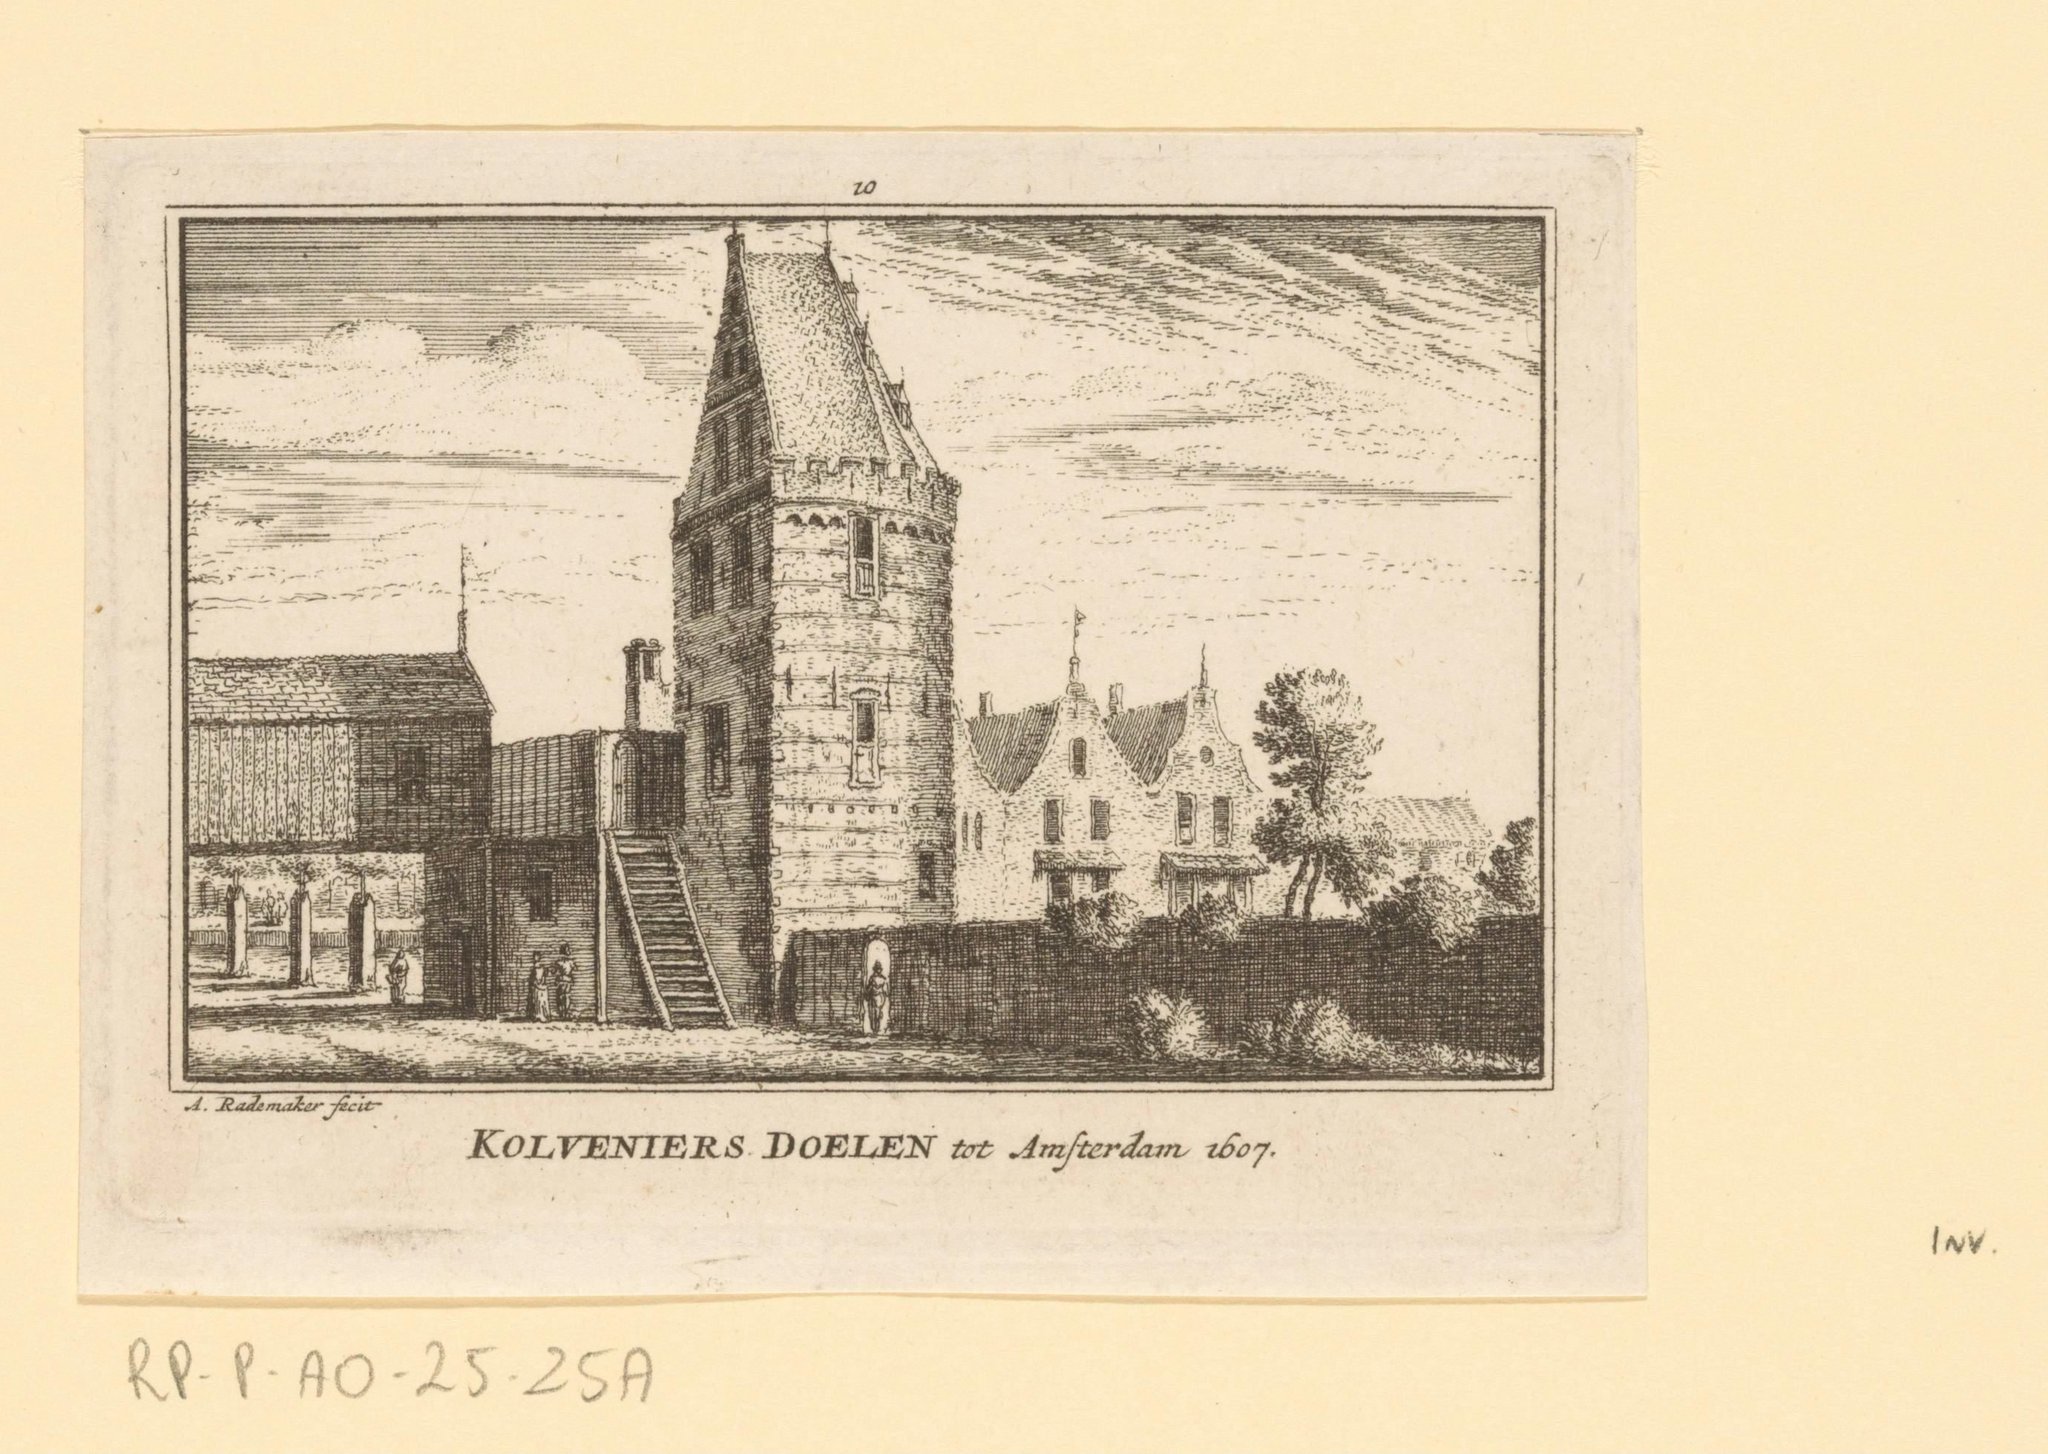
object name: print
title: Gezicht op de Kloveniersdoelen te Amsterdam, 1607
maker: abraham rademaker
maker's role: draughtsman, print maker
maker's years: 1676-1735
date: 1725-1803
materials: paper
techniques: engraving, etching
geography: amsterdam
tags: towers ~ fortified city, land forces (+ citizen soldiery, civil guard, citizen militia)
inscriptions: collector's mark: Lugt 2228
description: Prent ook gebruikt in: Rademaker, Abraham. Kabinet van Nederlandsche outheden en gezichten: vervat in 300 konstplaaten (…). 2 delen. Amsterdam: Willem Barents, 1725, dl. 1, ill. 10. Na 1725 is deze prent nog in verschillende heruitgaven verschenen, uitgegeven in 1727-1733, 1770-1771 en 1792-1803. Uit welke uitgave het huidige exemplaar precies komt is niet na te gaan.